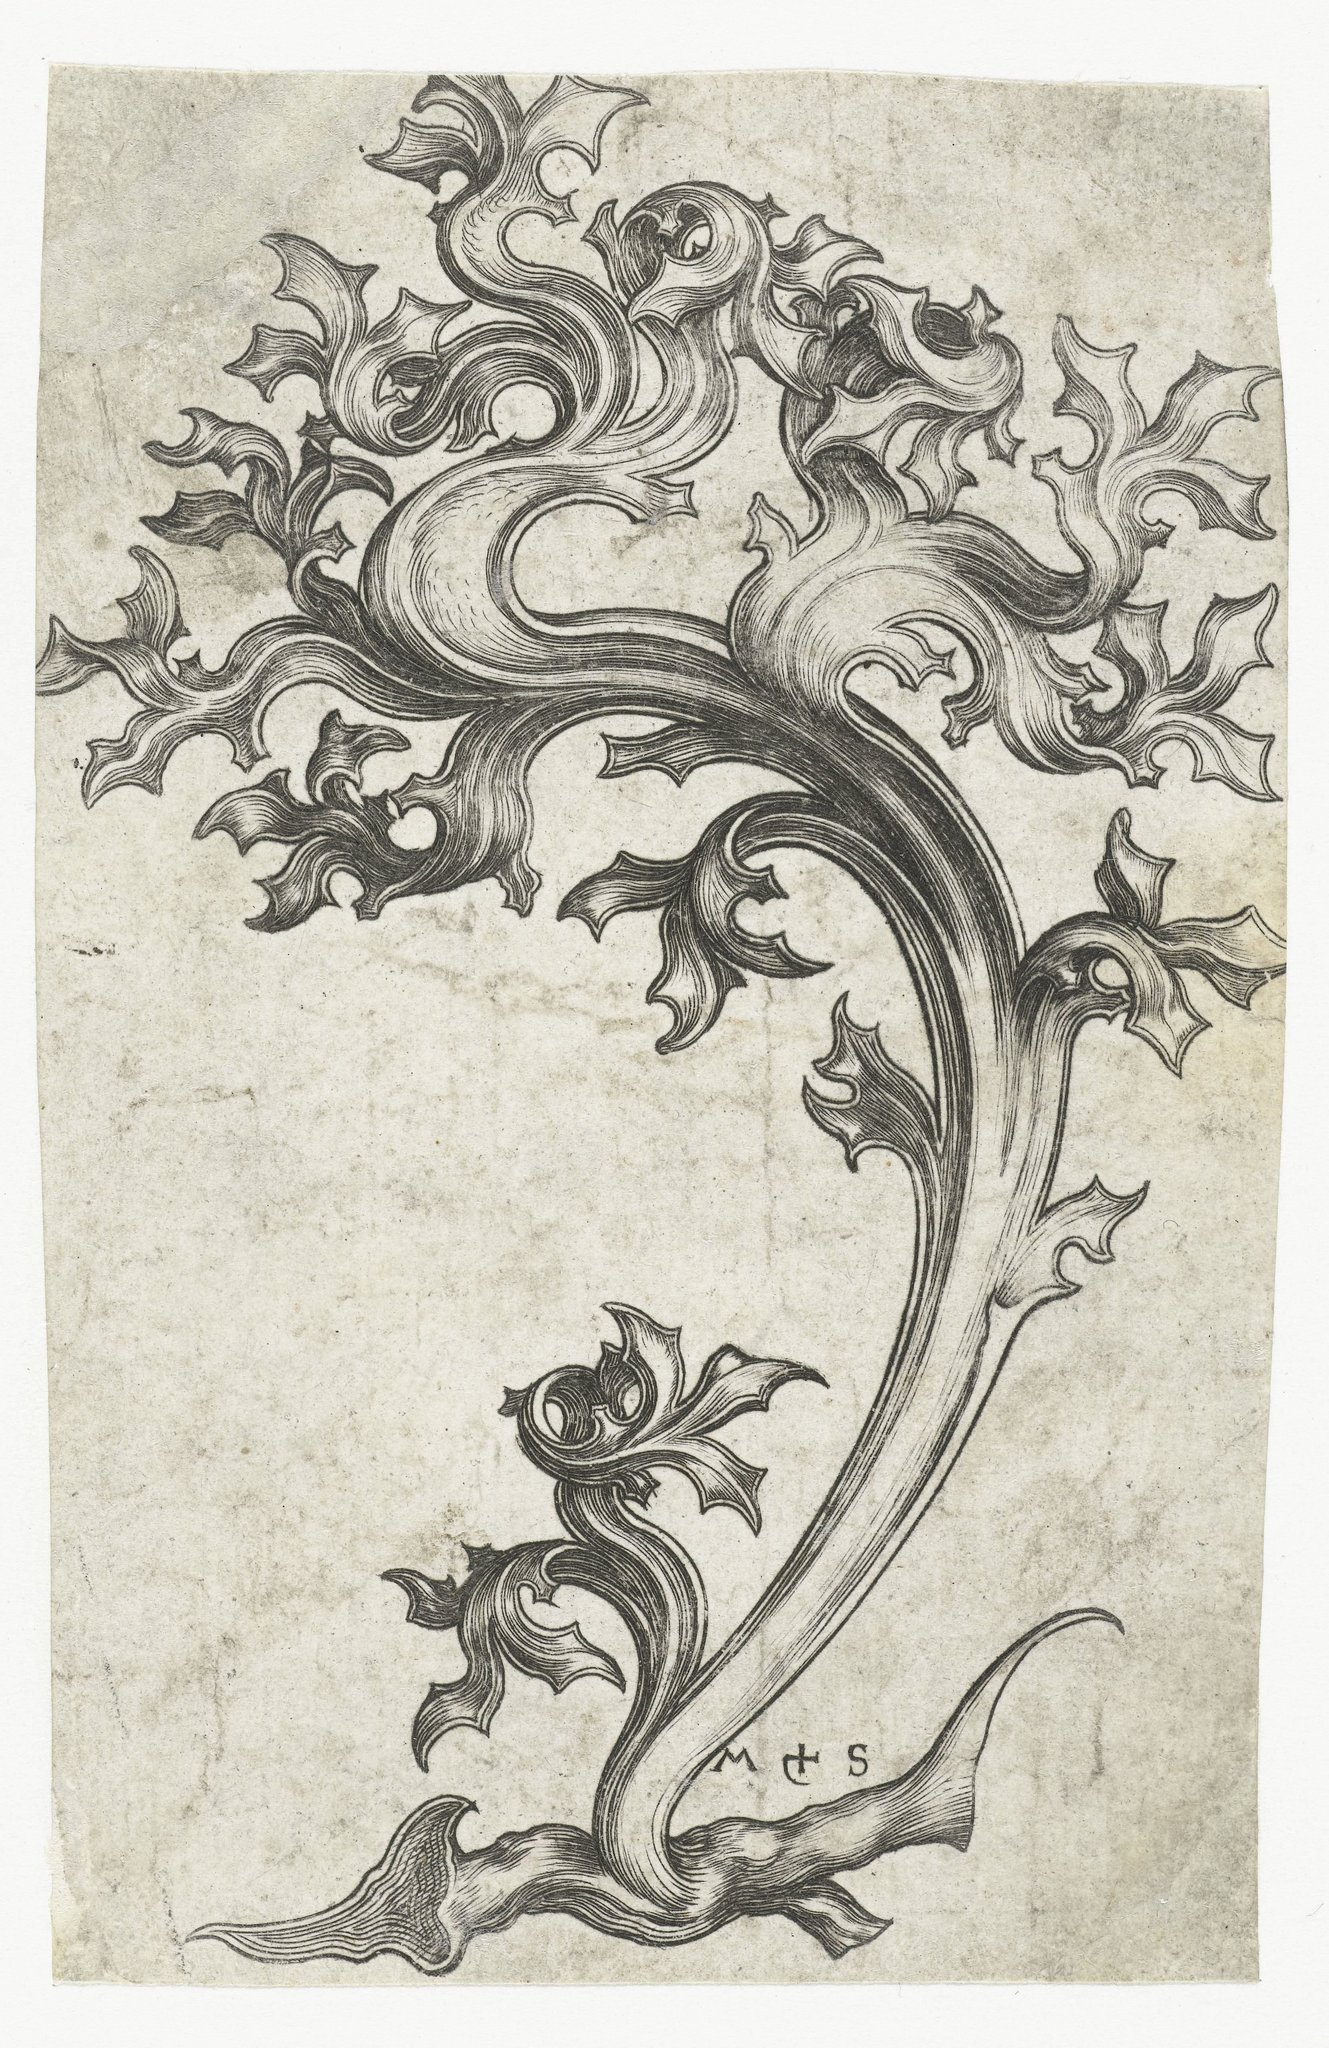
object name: ornament print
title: bladornament (distel)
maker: martin schongauer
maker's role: print maker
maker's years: 1430-1491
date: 1470-1491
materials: paper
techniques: engraving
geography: germany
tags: plants and herbs: thistle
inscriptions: collector's mark: Lugt 2228a